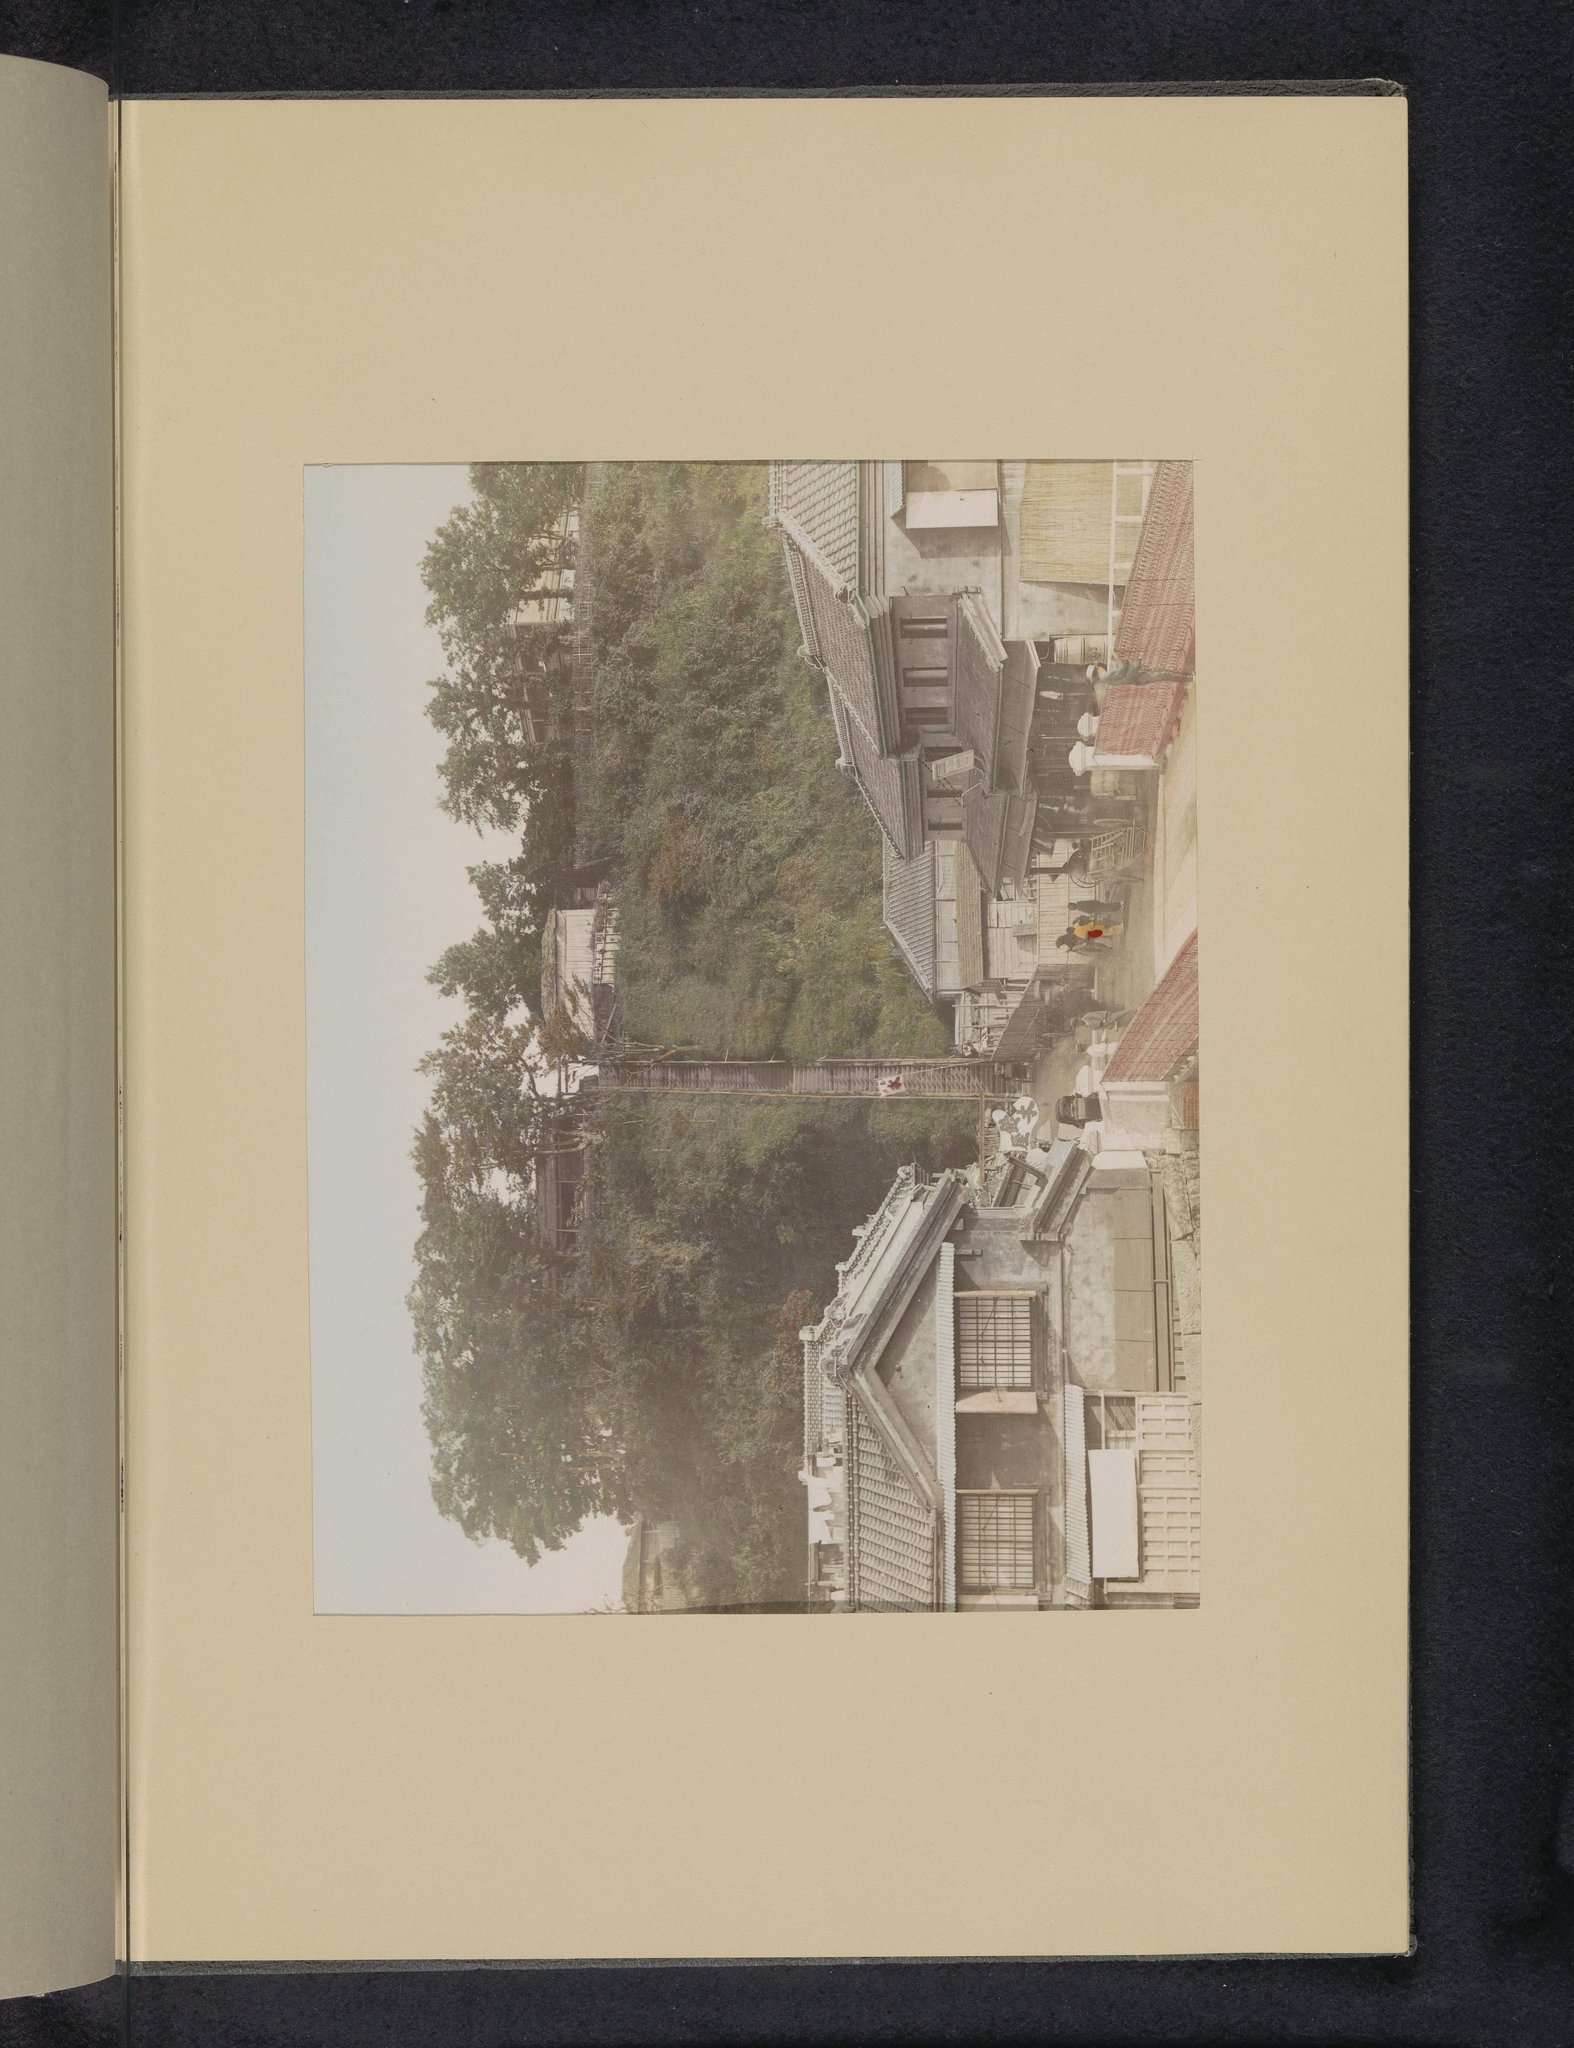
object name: page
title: Gezicht op de honderd treden tellende trap te Yokohama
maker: Anonymous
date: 1887-1897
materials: photographic support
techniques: albumen print, hand coloring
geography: japan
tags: staircase, façade (of house or building), street